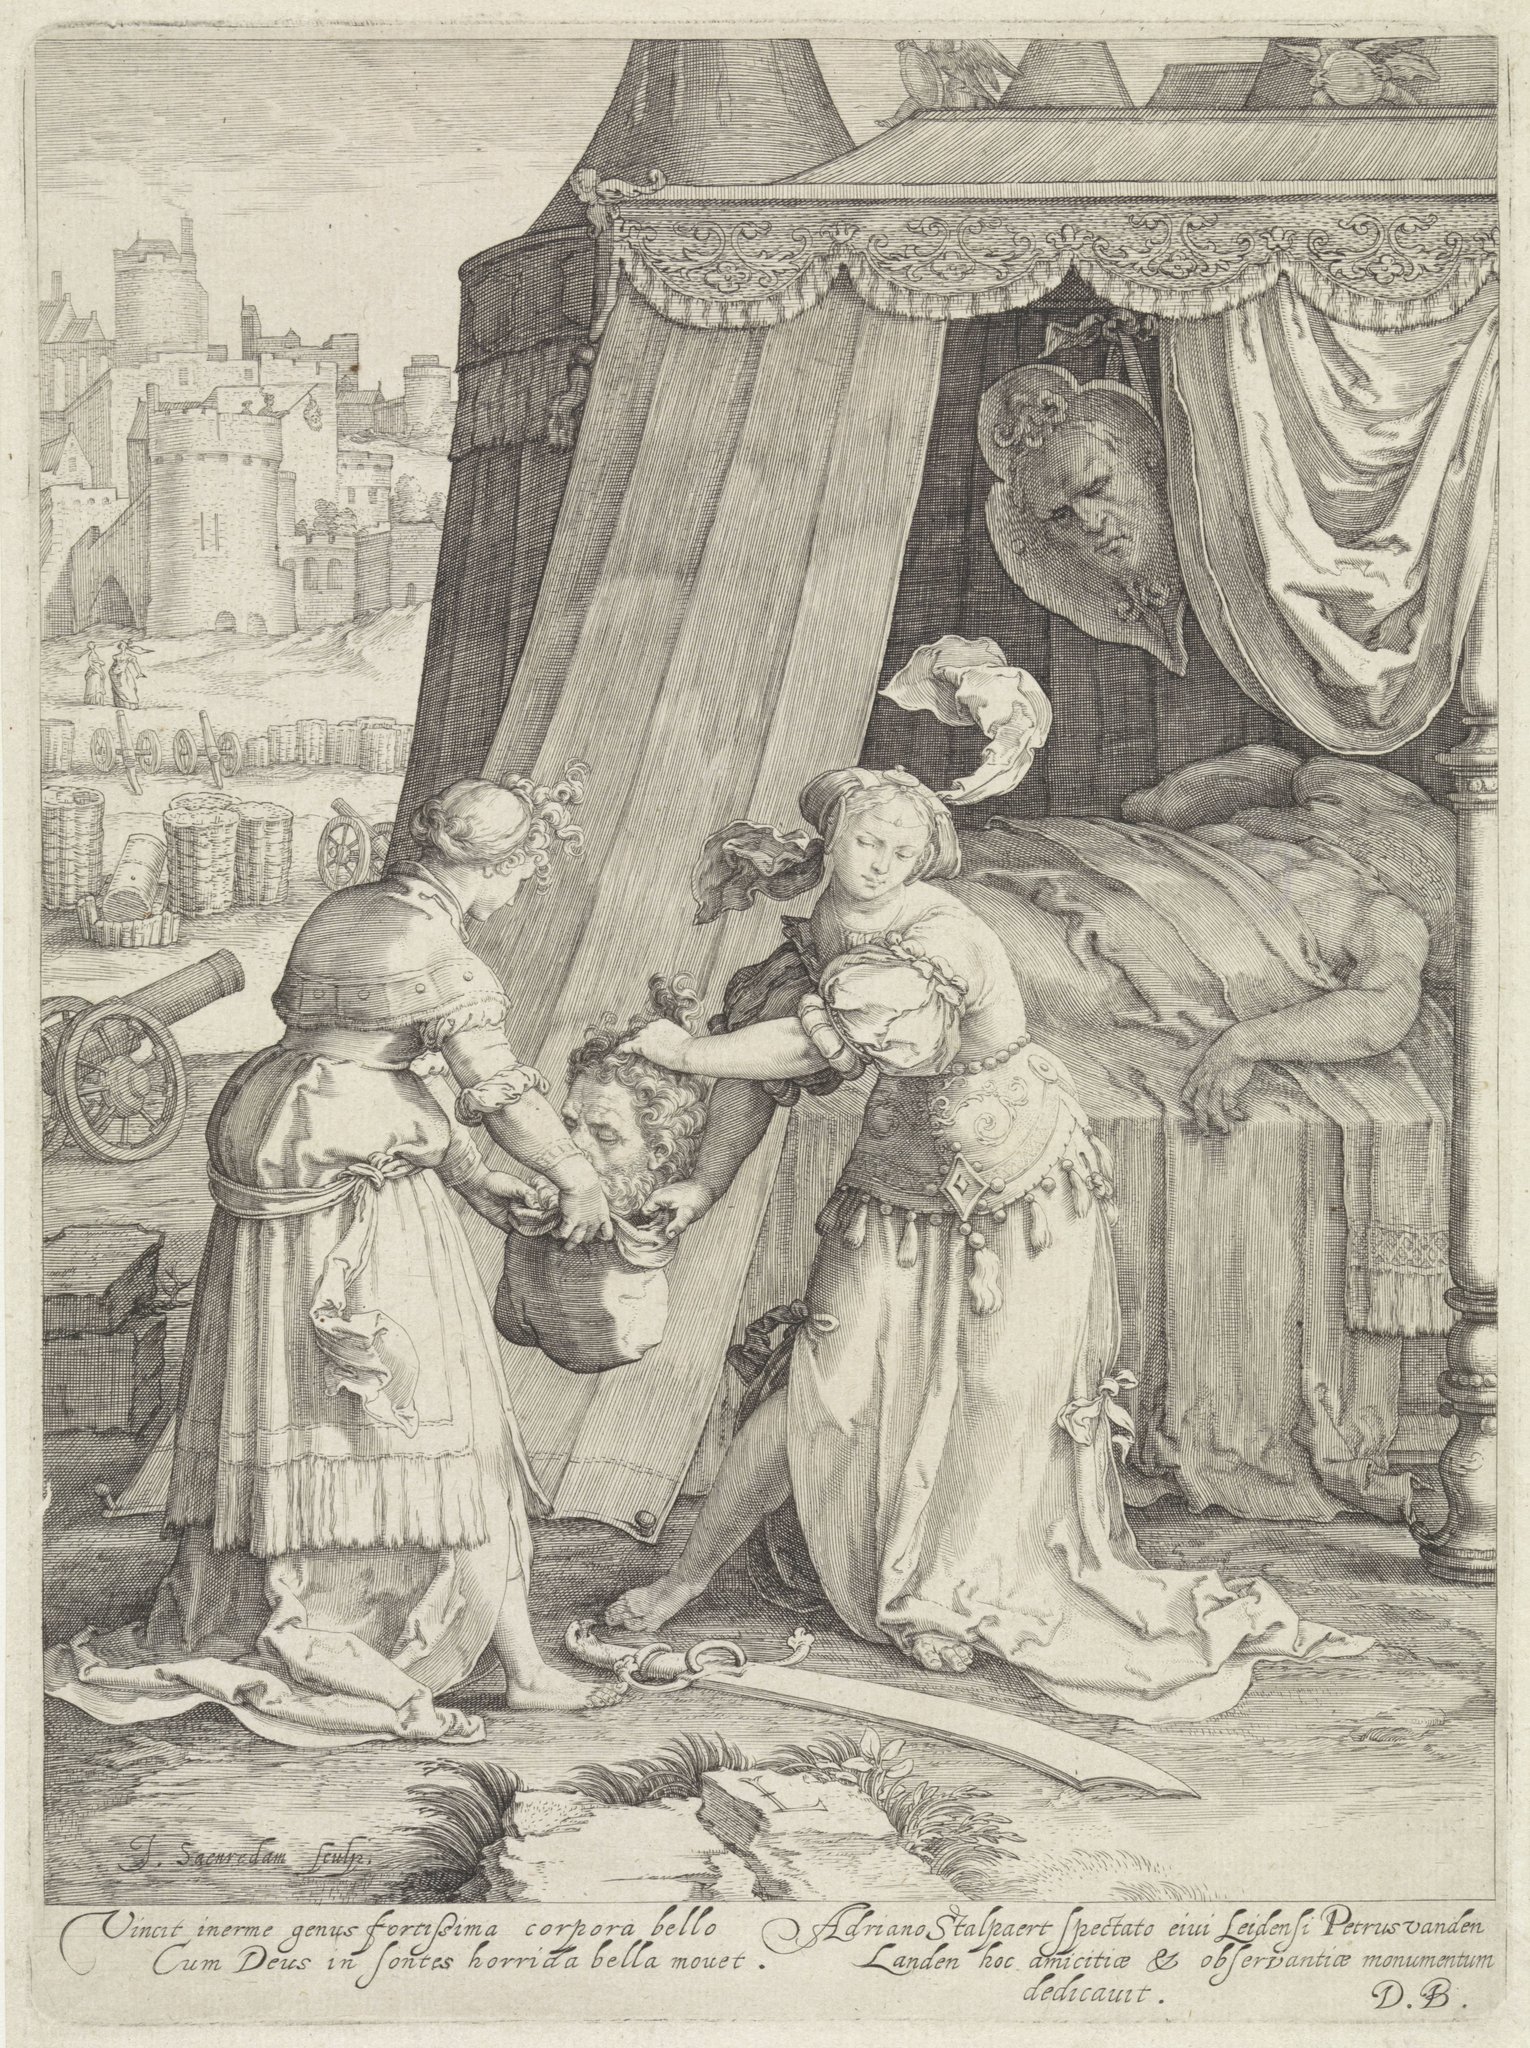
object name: print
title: Judit met het hoofd van Holofernes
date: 1589-1607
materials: paper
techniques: engraving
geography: northern netherlands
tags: judith and her maidservant put holofernes' head in a sack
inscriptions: collector's mark: Lugt 240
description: Judit stopt samen met haar bediende het hoofd van Holofernes in een zaak. Bij haar voeten ligt zijn zwaard. Achter haar ligt het lichaam van Holofernes in bed. Boven hem hangt een schild met het gezicht van een man. Links achter een burcht. Onder de voorstelling een tweeregelige, Latijnse tekst met commentaar op de voorstelling en een tekst met een opdracht.